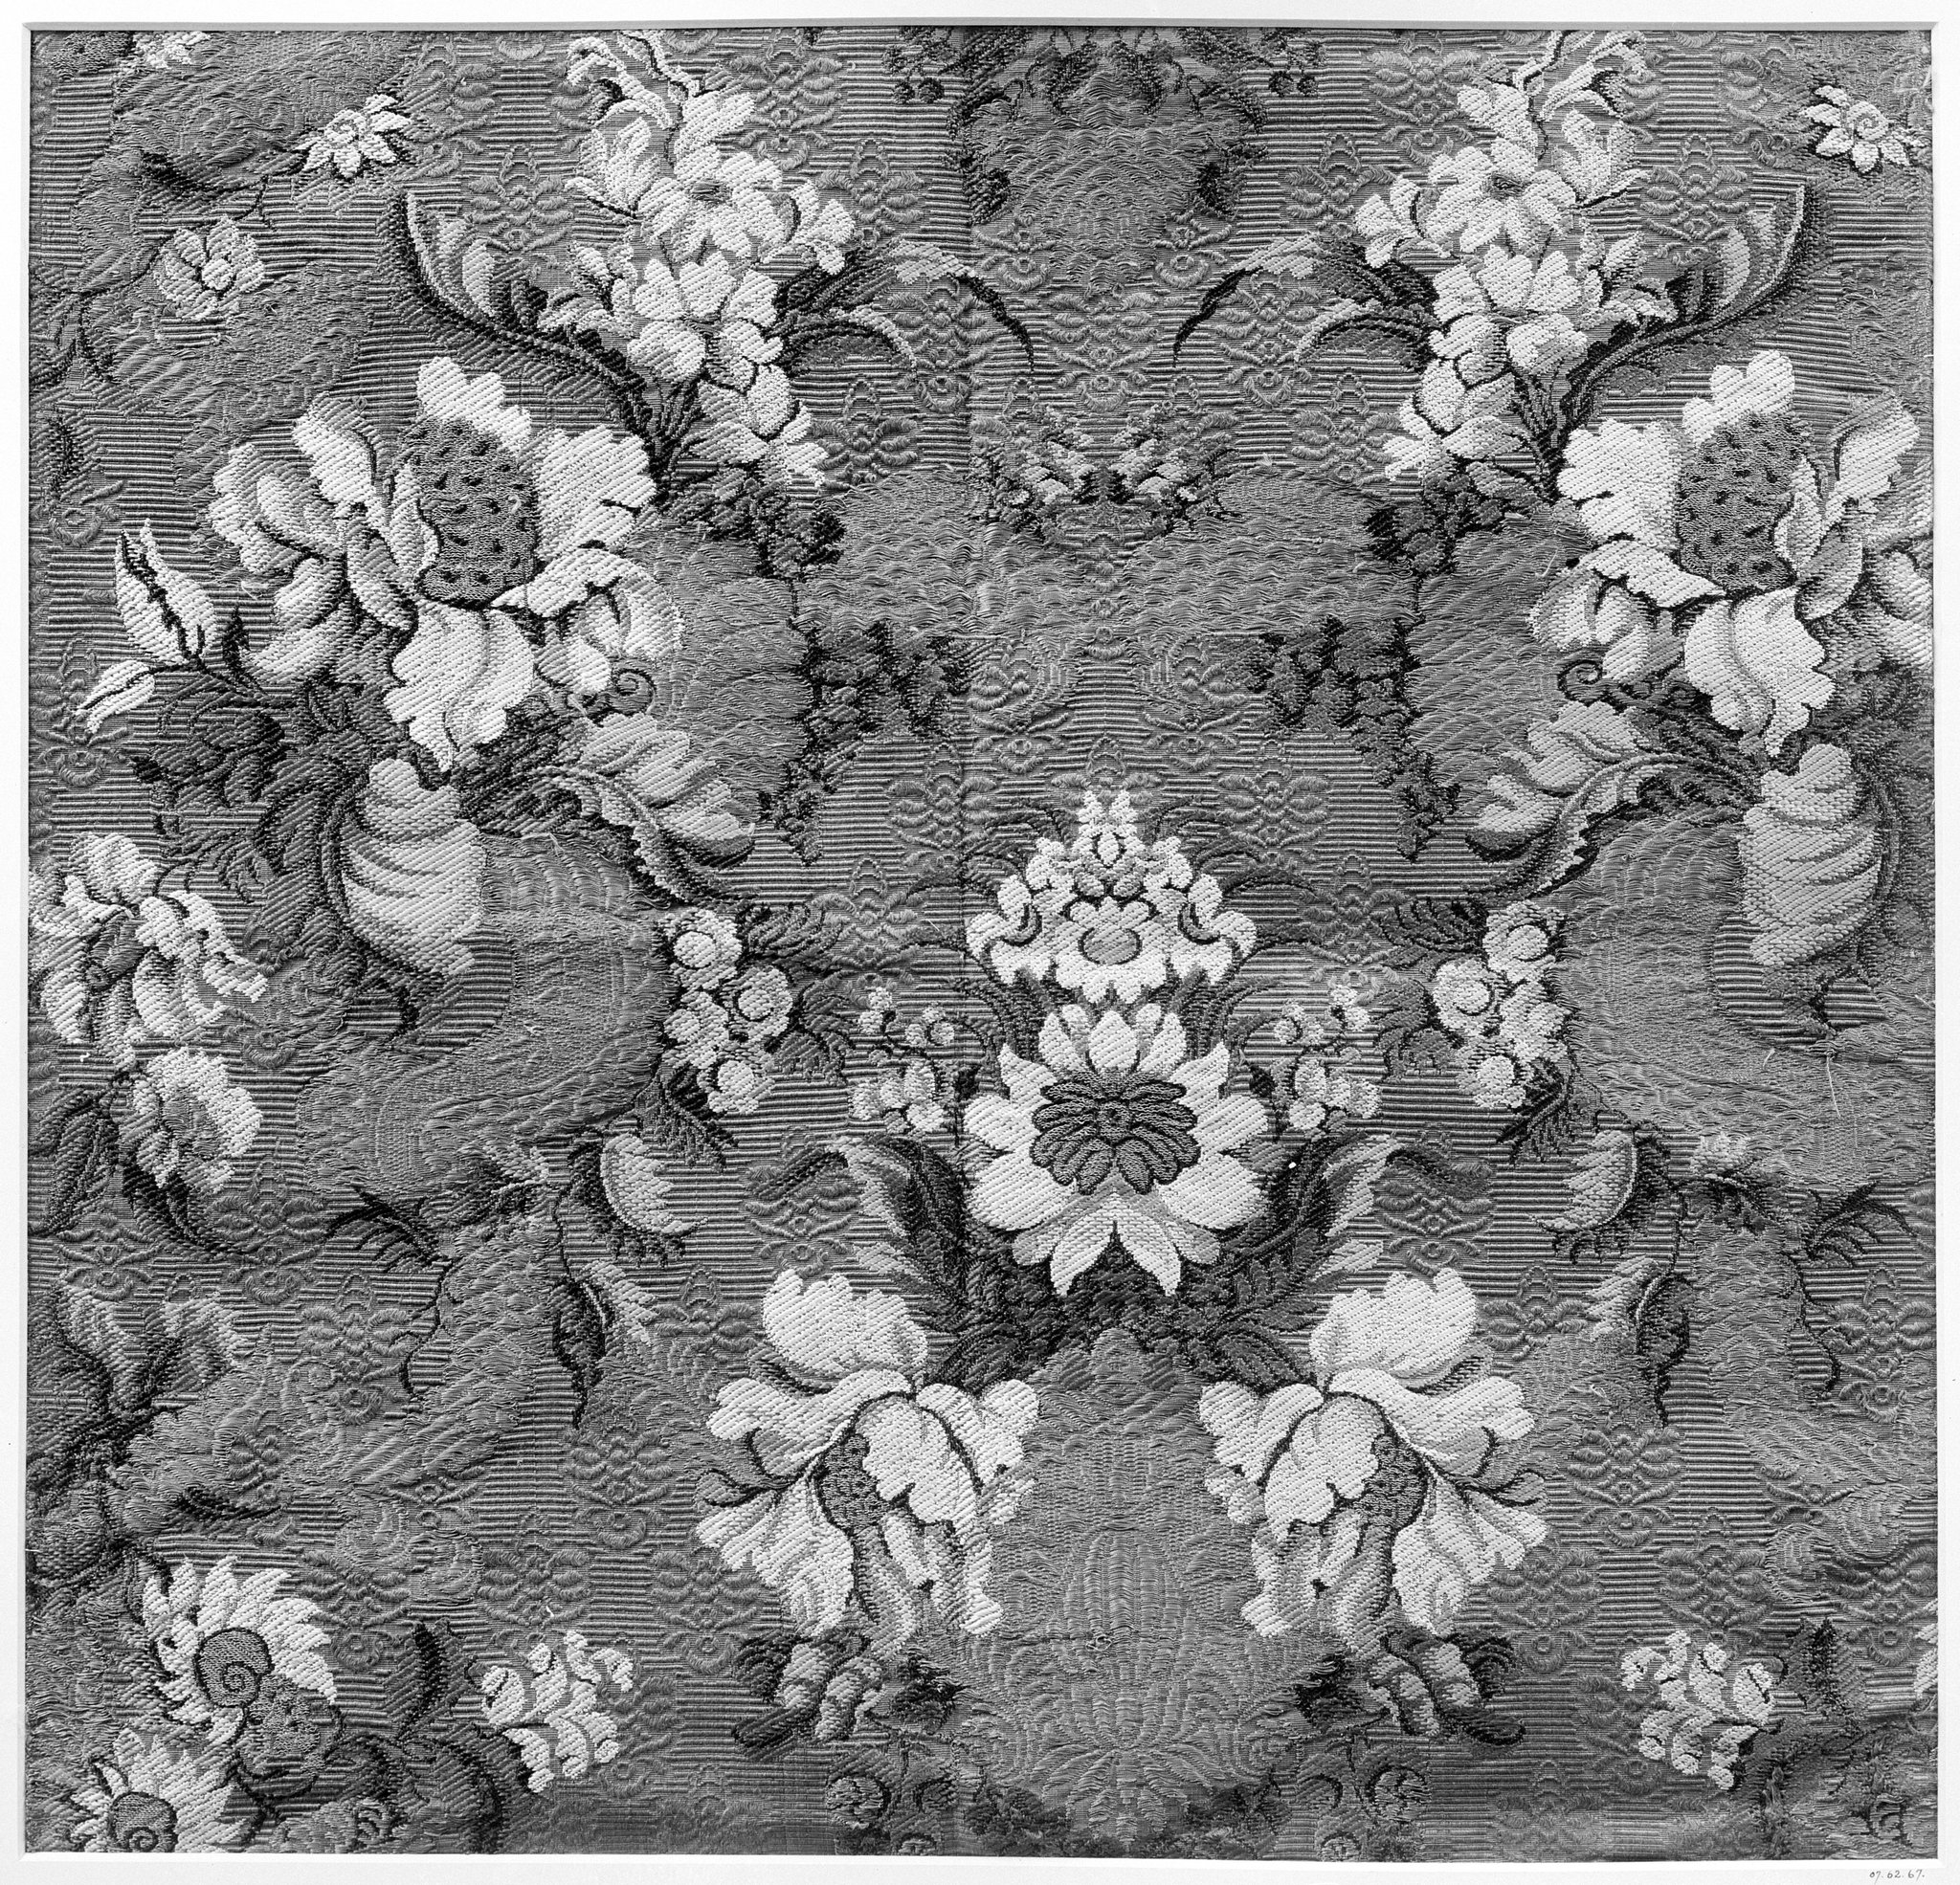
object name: piece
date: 1735-1740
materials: metal thread, silk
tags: flowers,leaves